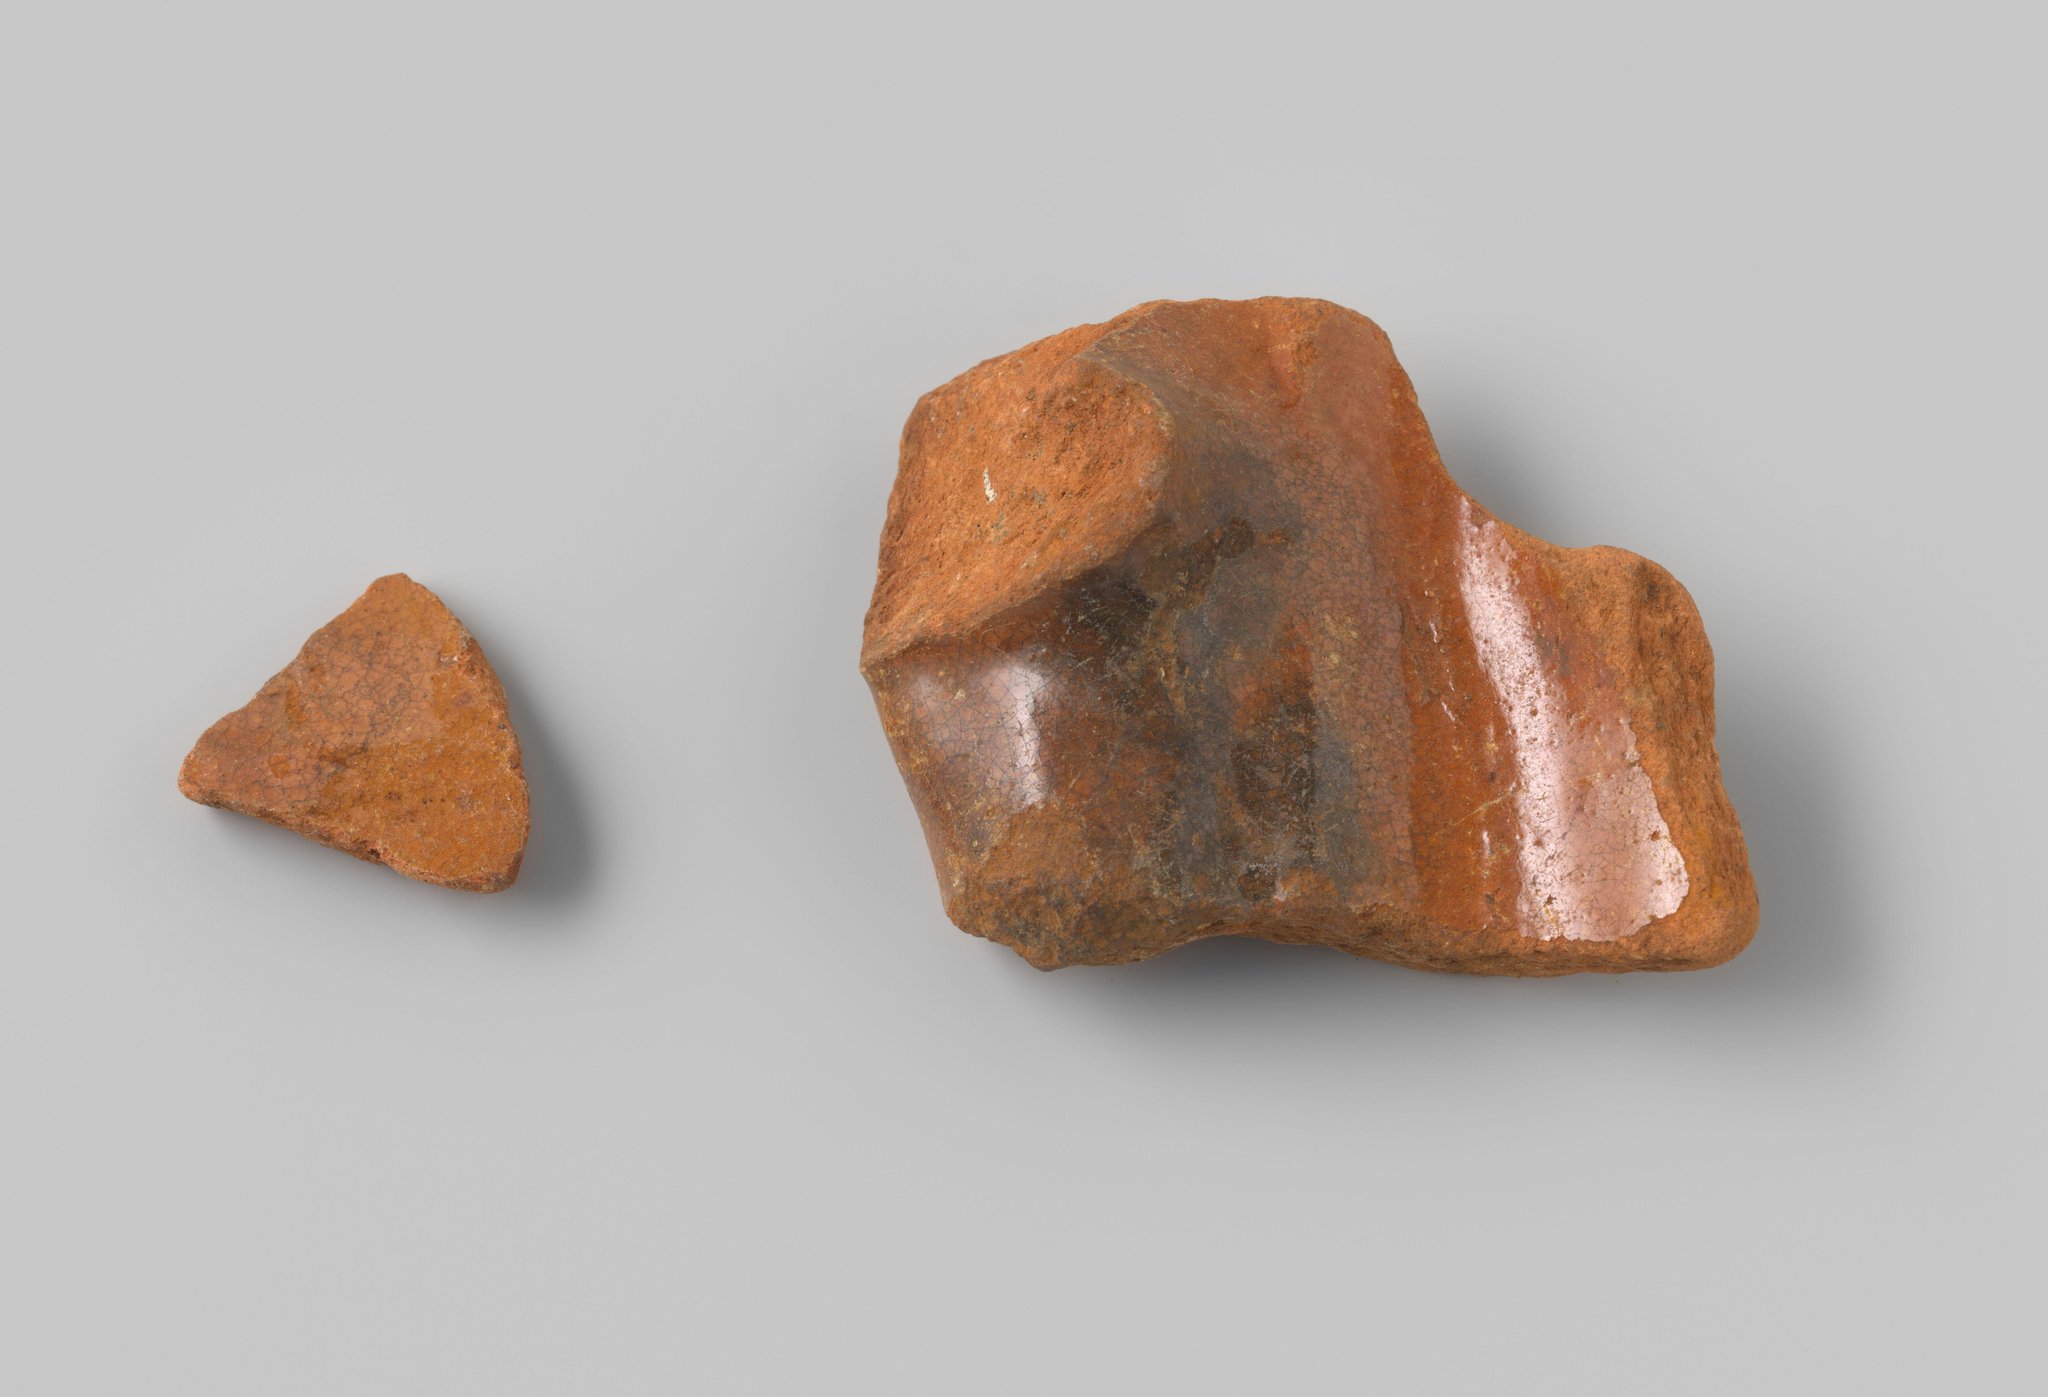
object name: pot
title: Scherven van een pot of schaal uit het wrak van de Oost-Indiëvaarder Hollandia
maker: Anonymous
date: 1700-1743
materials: earthenware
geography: netherlands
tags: verenigde oostindische compagnie, hollandia (schip), annet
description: Earthenware (lead-glazed), pot or dish (hollow ware); fragm of rim, straight, with join of looped or straight handle on the outside, stepped inside, glazed on both sides.